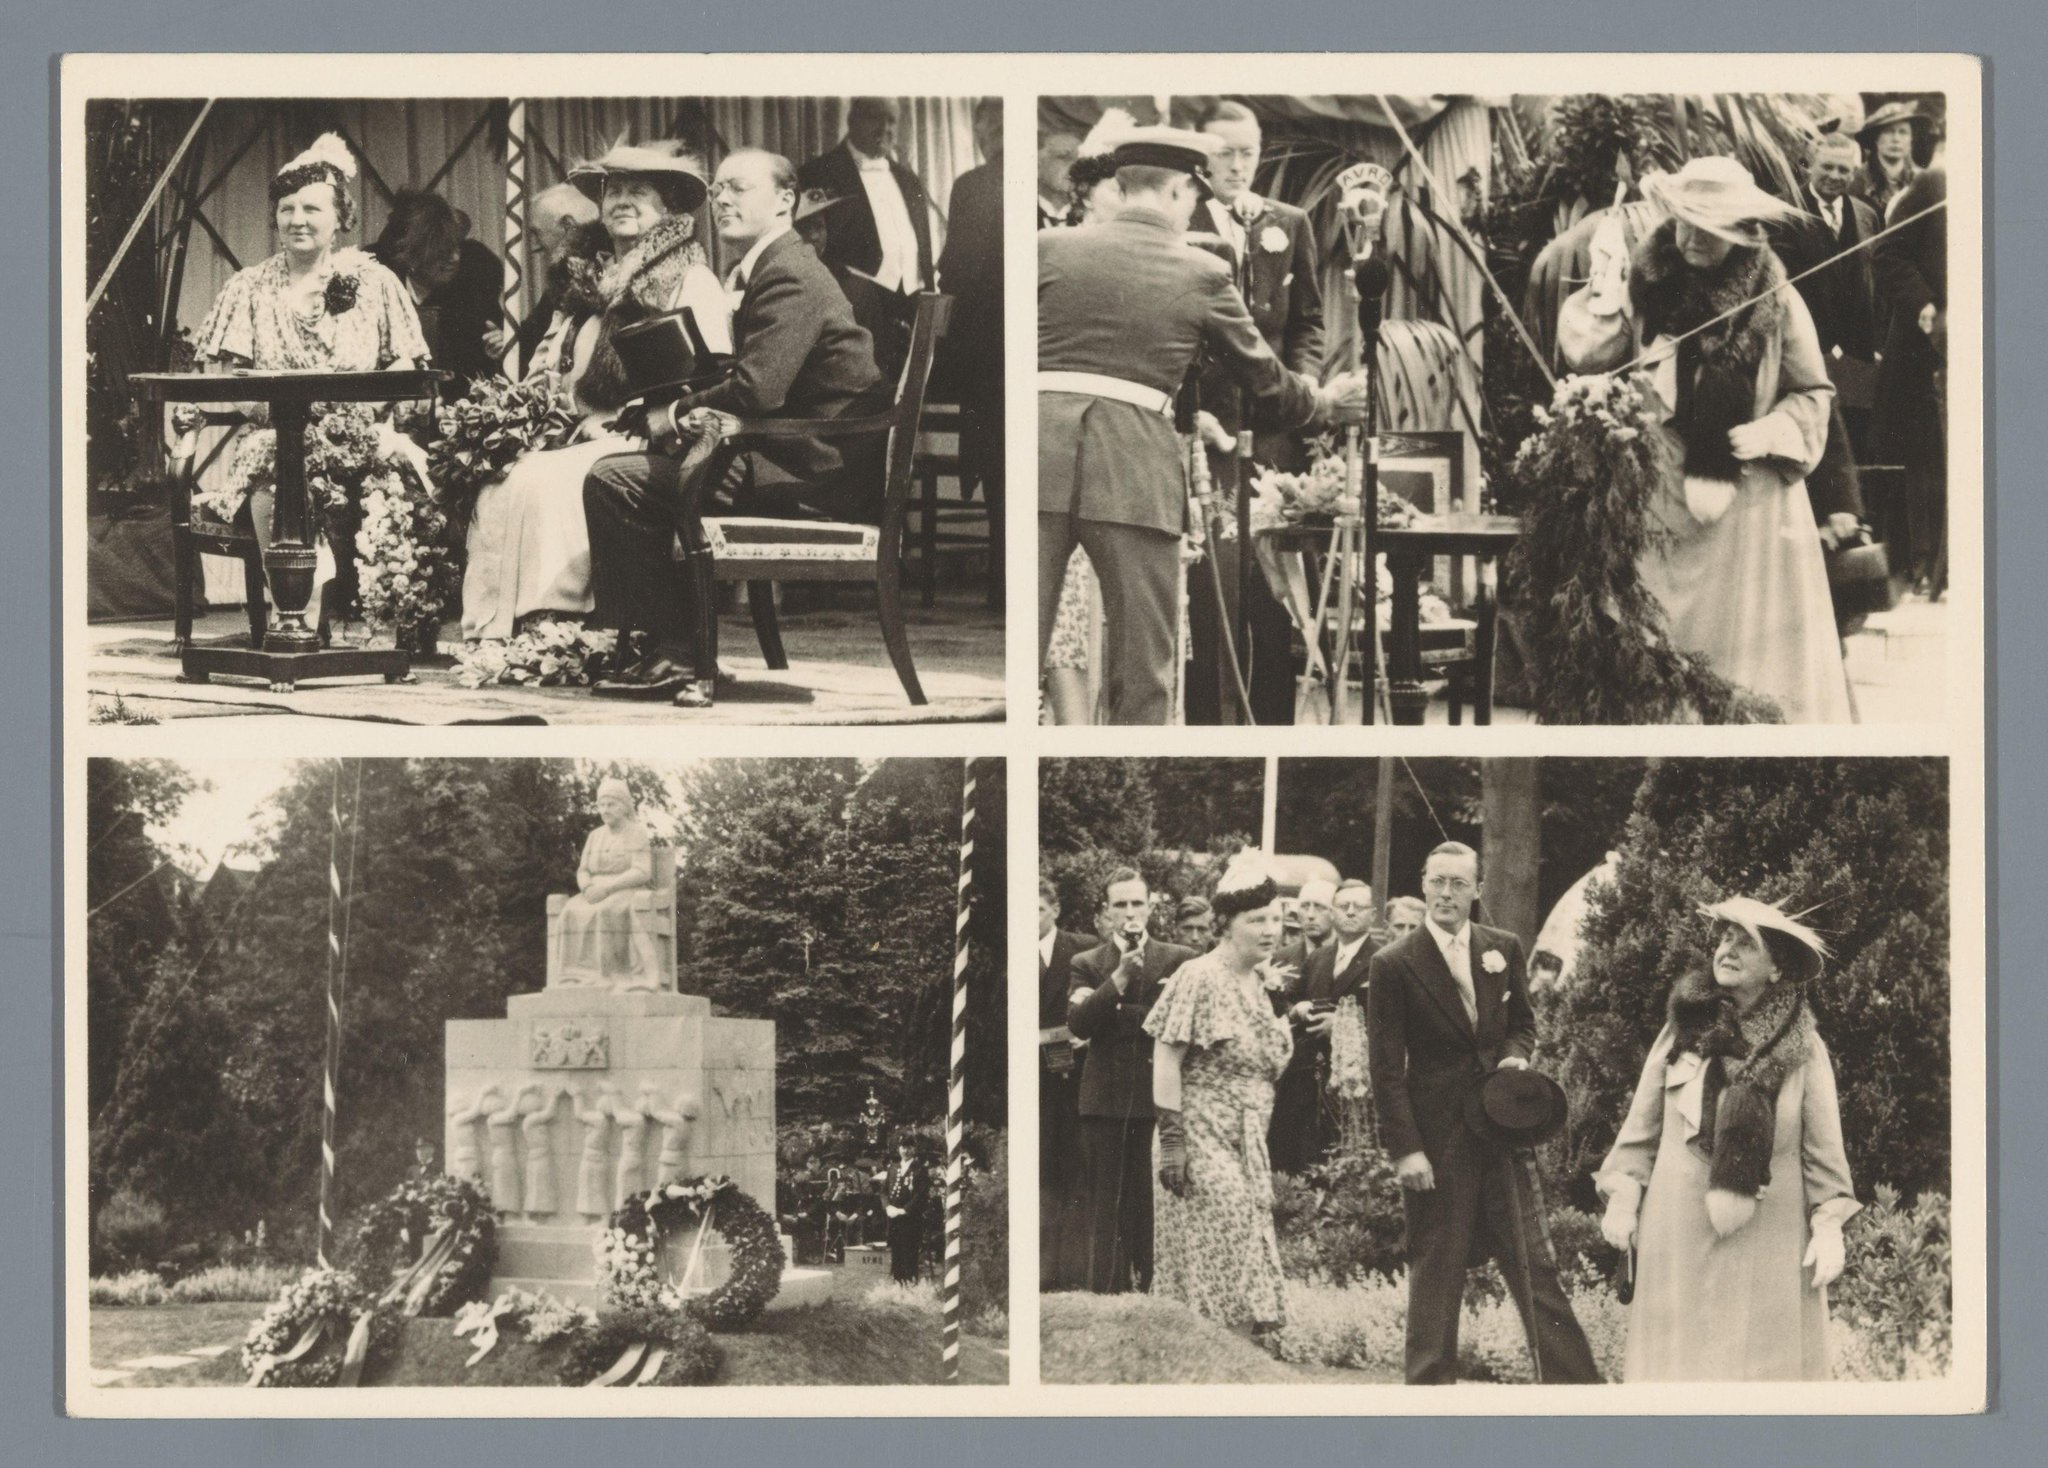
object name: ansichtkaart, prentbriefkaart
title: Onthulling van het monument van wijlen H.M. koningin Emma te Amsterdam, 17 Juni 1938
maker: Anonymous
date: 1938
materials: photographic support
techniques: gelatin silver print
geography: amsterdam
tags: the hague, print maker, wilhelmina of the netherlands, emma (queen consort of the netherlands), utrecht, bernhard (prins der nederlanden), juliana of the netherlands, crown princess, prince, queen, monument, statue, amsterdam